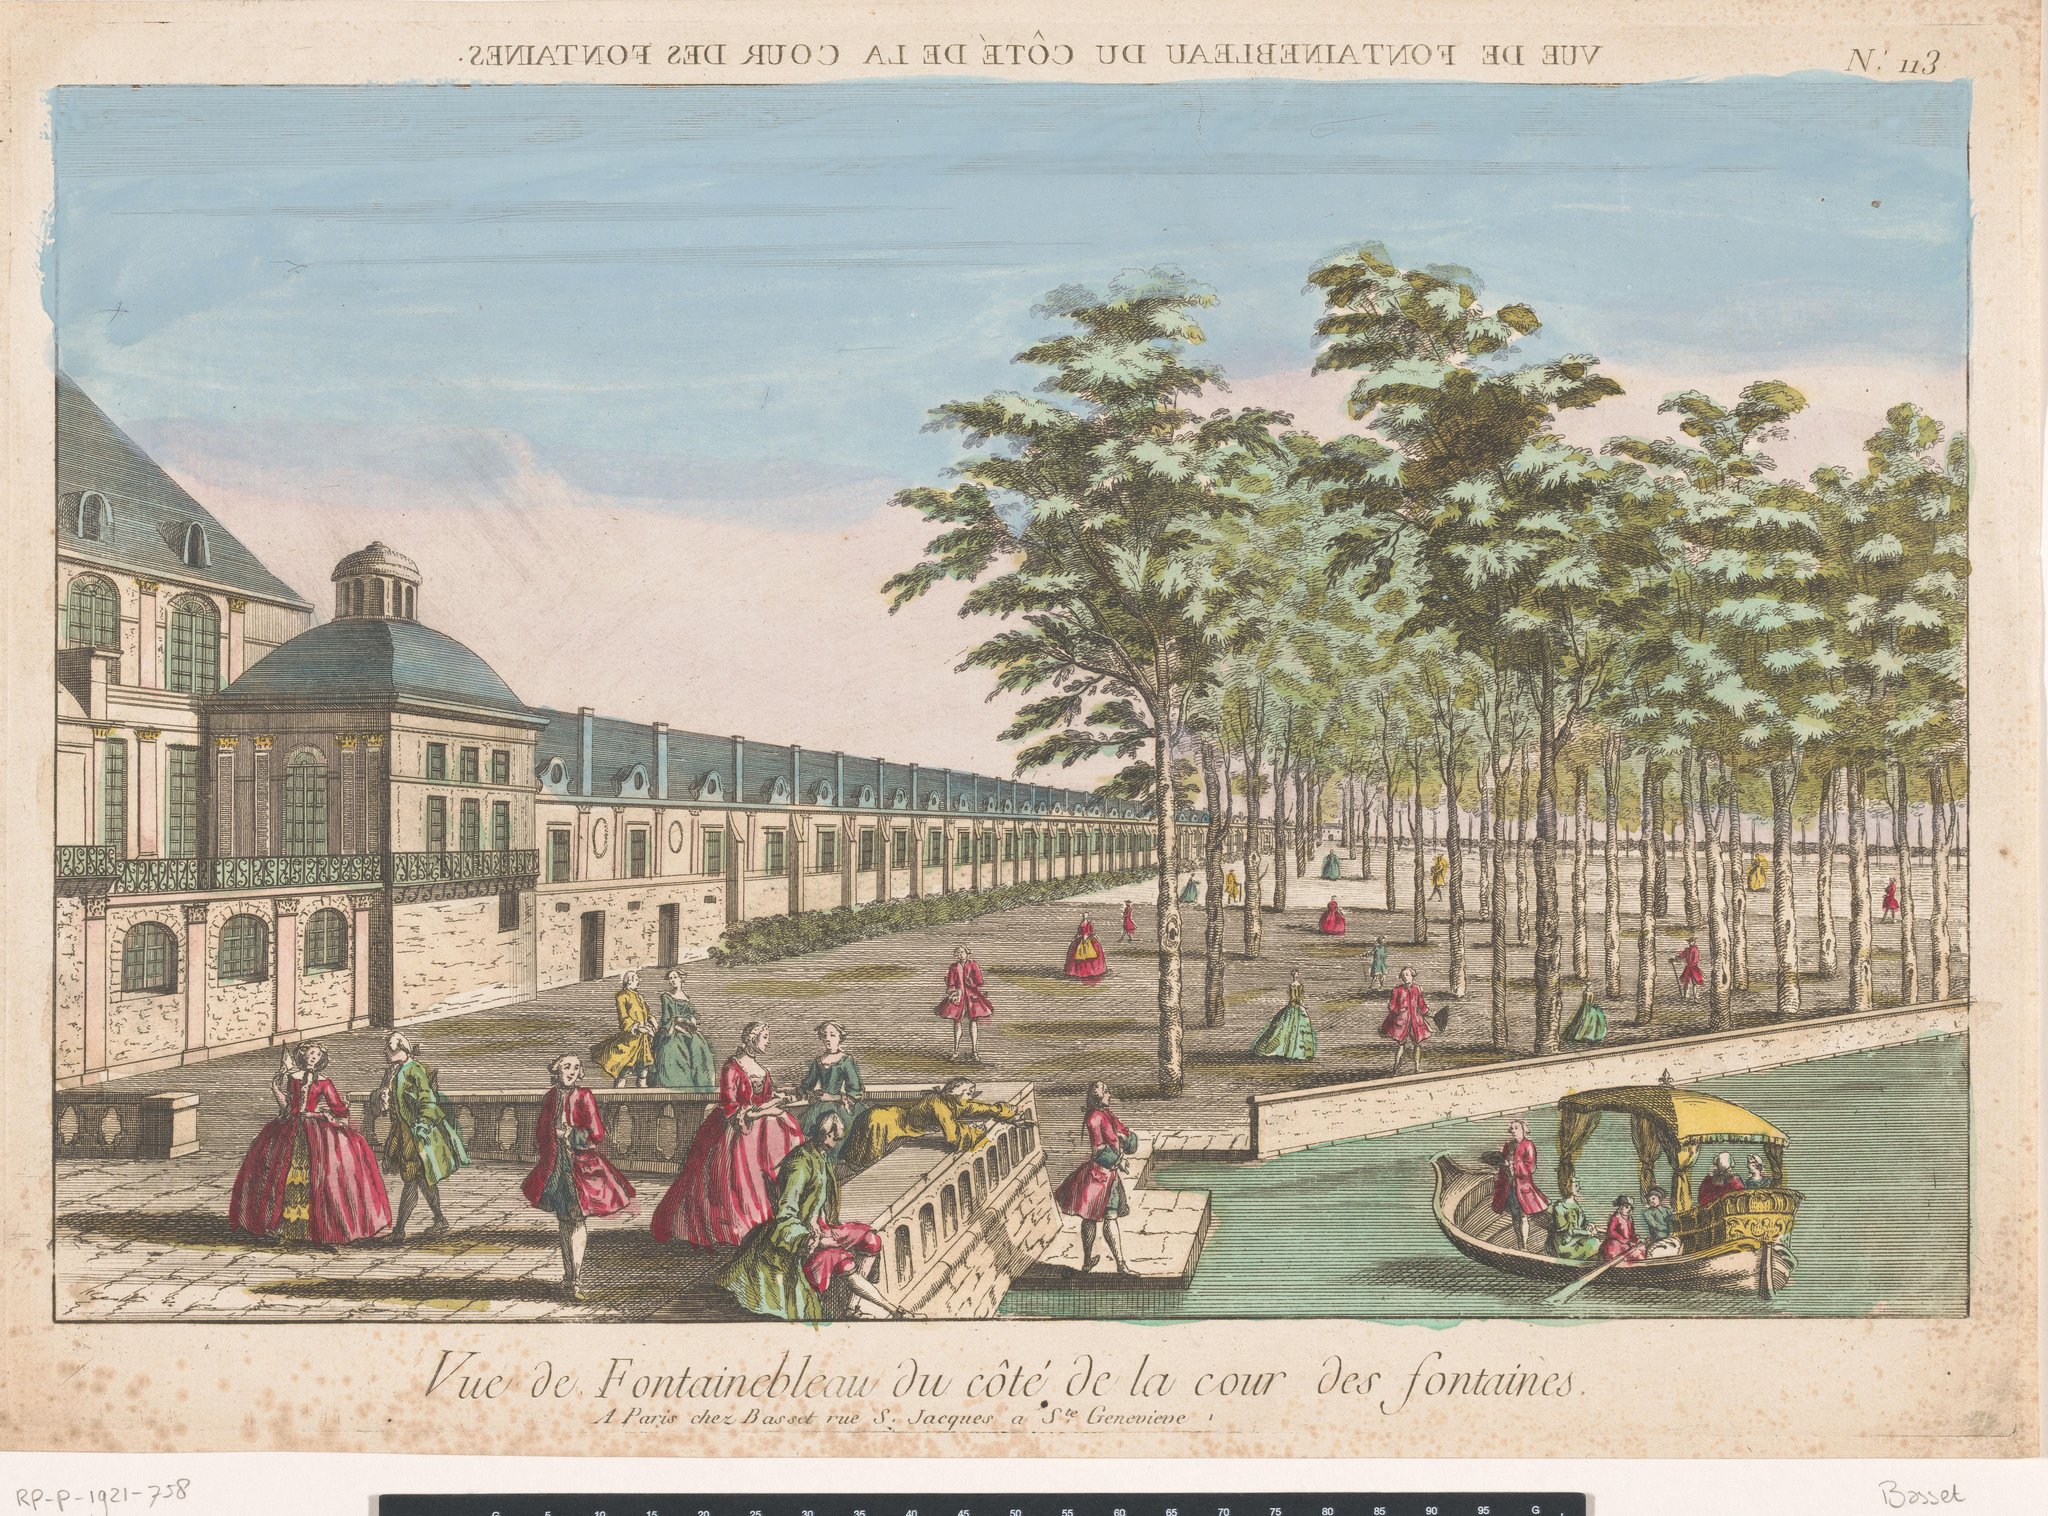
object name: print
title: Vue de Fontainebleau du côté de la Cour des Fontaines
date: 1700-1799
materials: paper, watercolor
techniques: brush, etching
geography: paris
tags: palace, rowing-boat, canoe, etc., inner court of palace or 'hôtel'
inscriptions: watermark, collector's mark: Lugt 2233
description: Rechts vaart een overdekte roeiboot met een aantal figuren op het water. Genummerd: 113.